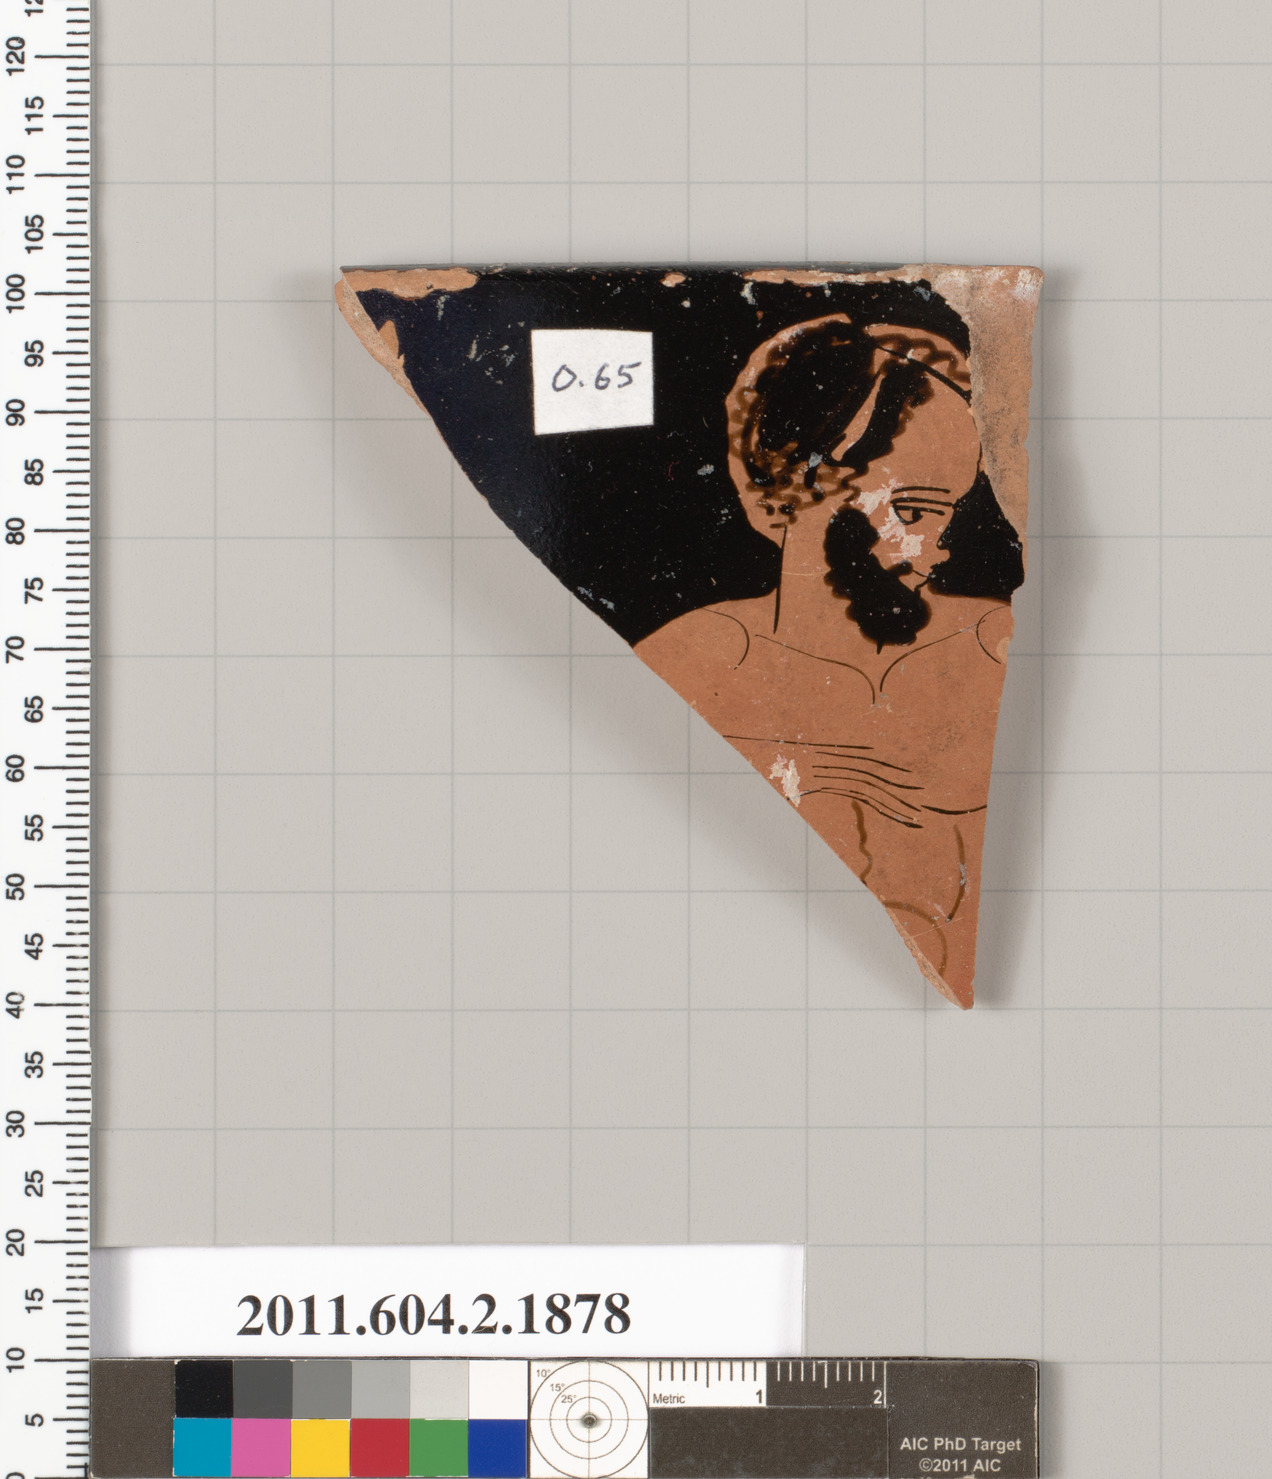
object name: skyphos fragment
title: Terracotta rim fragment of a skyphos (deep drinking cup)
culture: greek, attic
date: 430-420 BCE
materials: terracotta